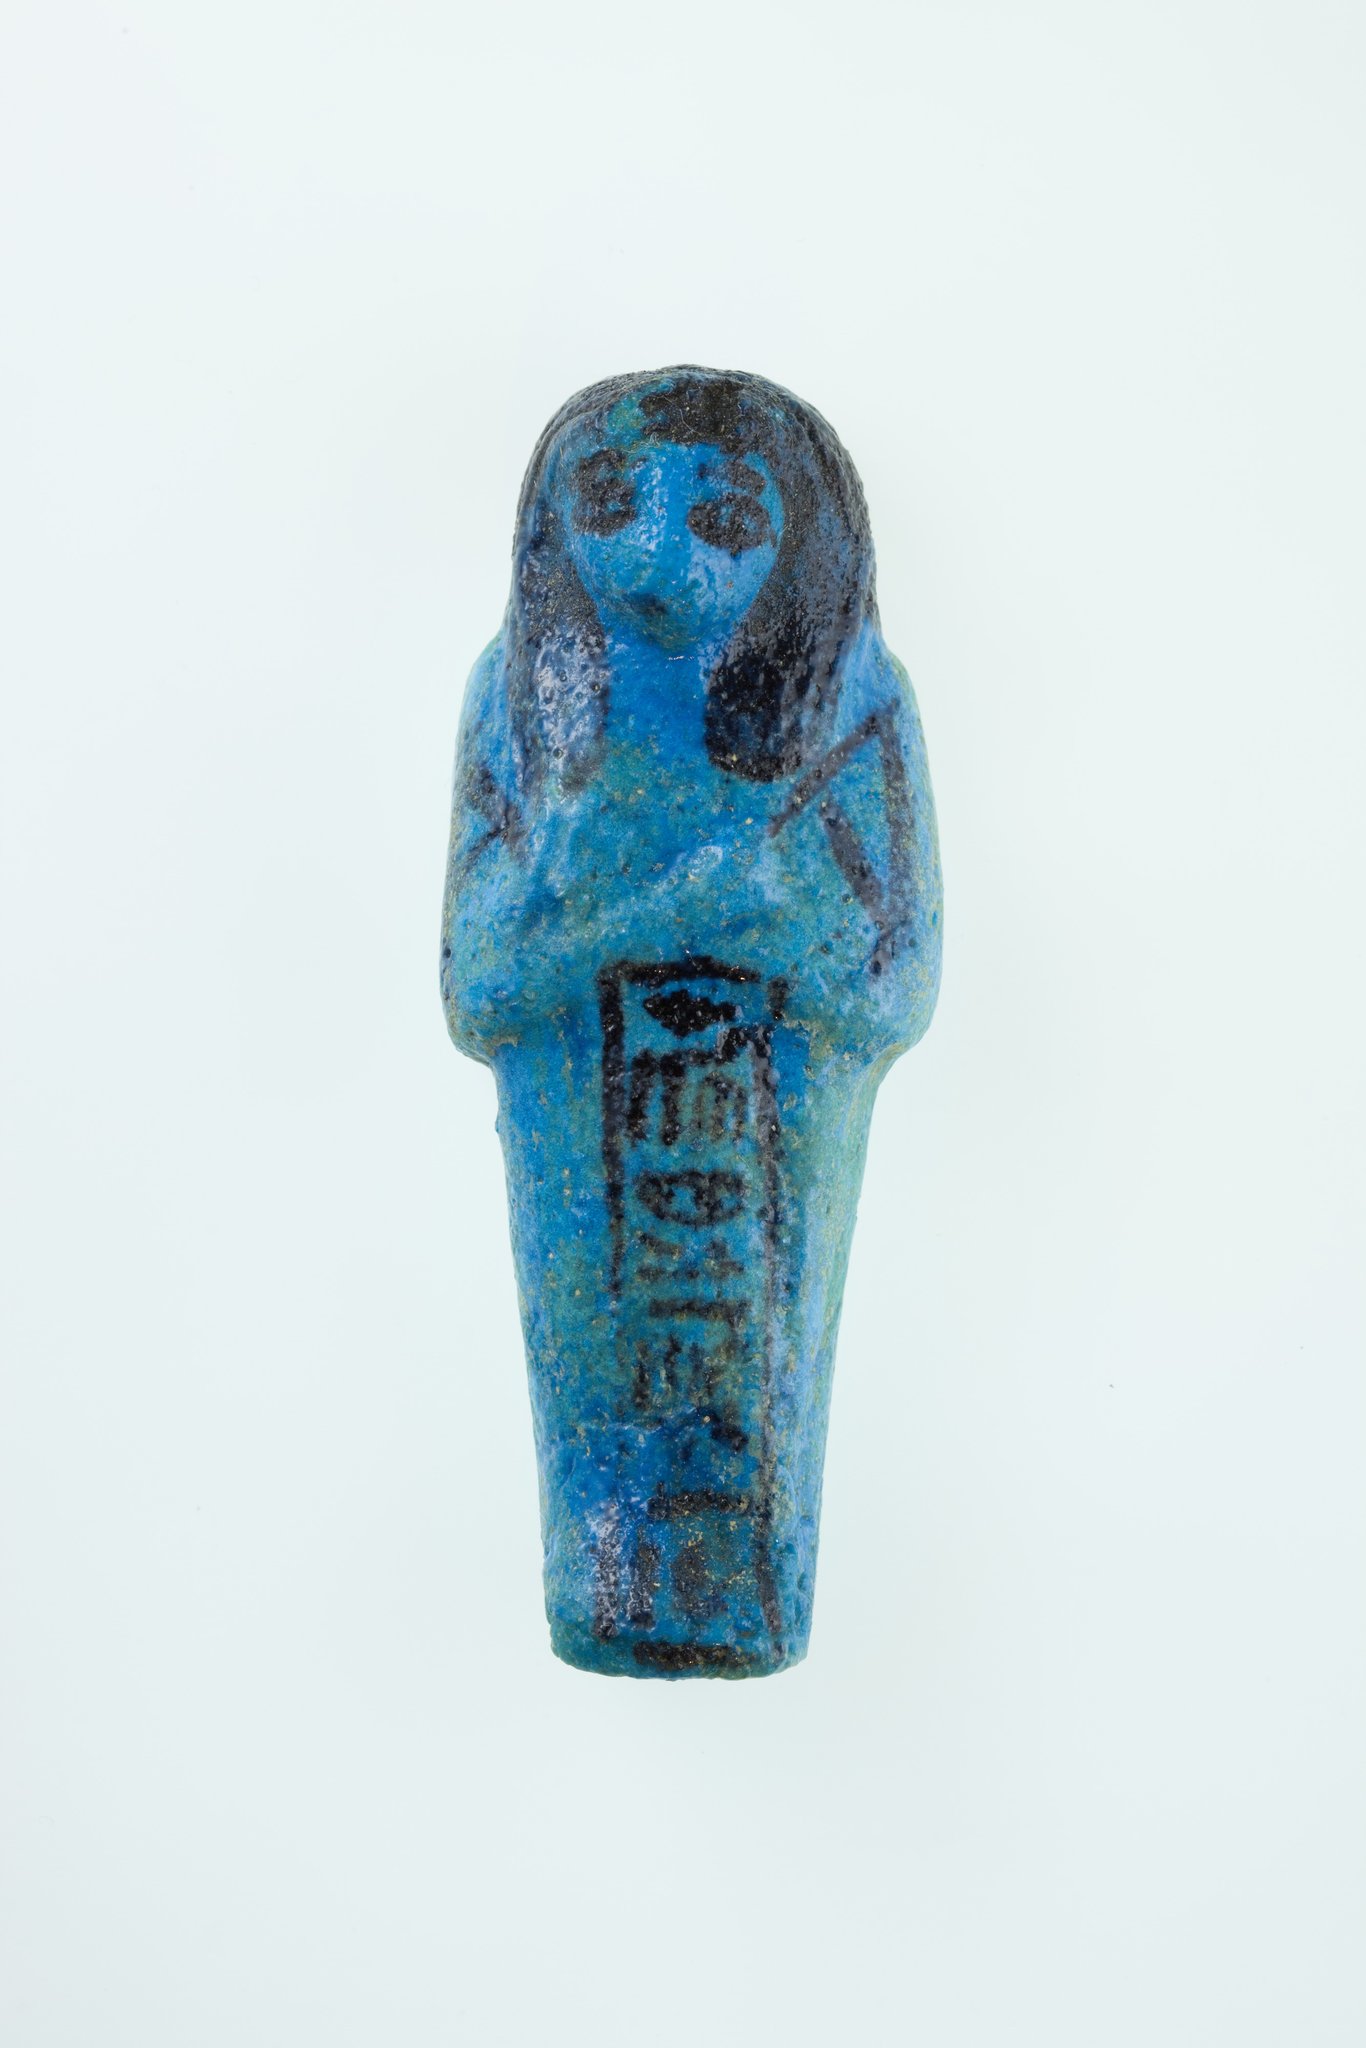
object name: shabti, worker, nauny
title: Worker Shabti of Nauny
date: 1050 BCE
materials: faience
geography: egypt